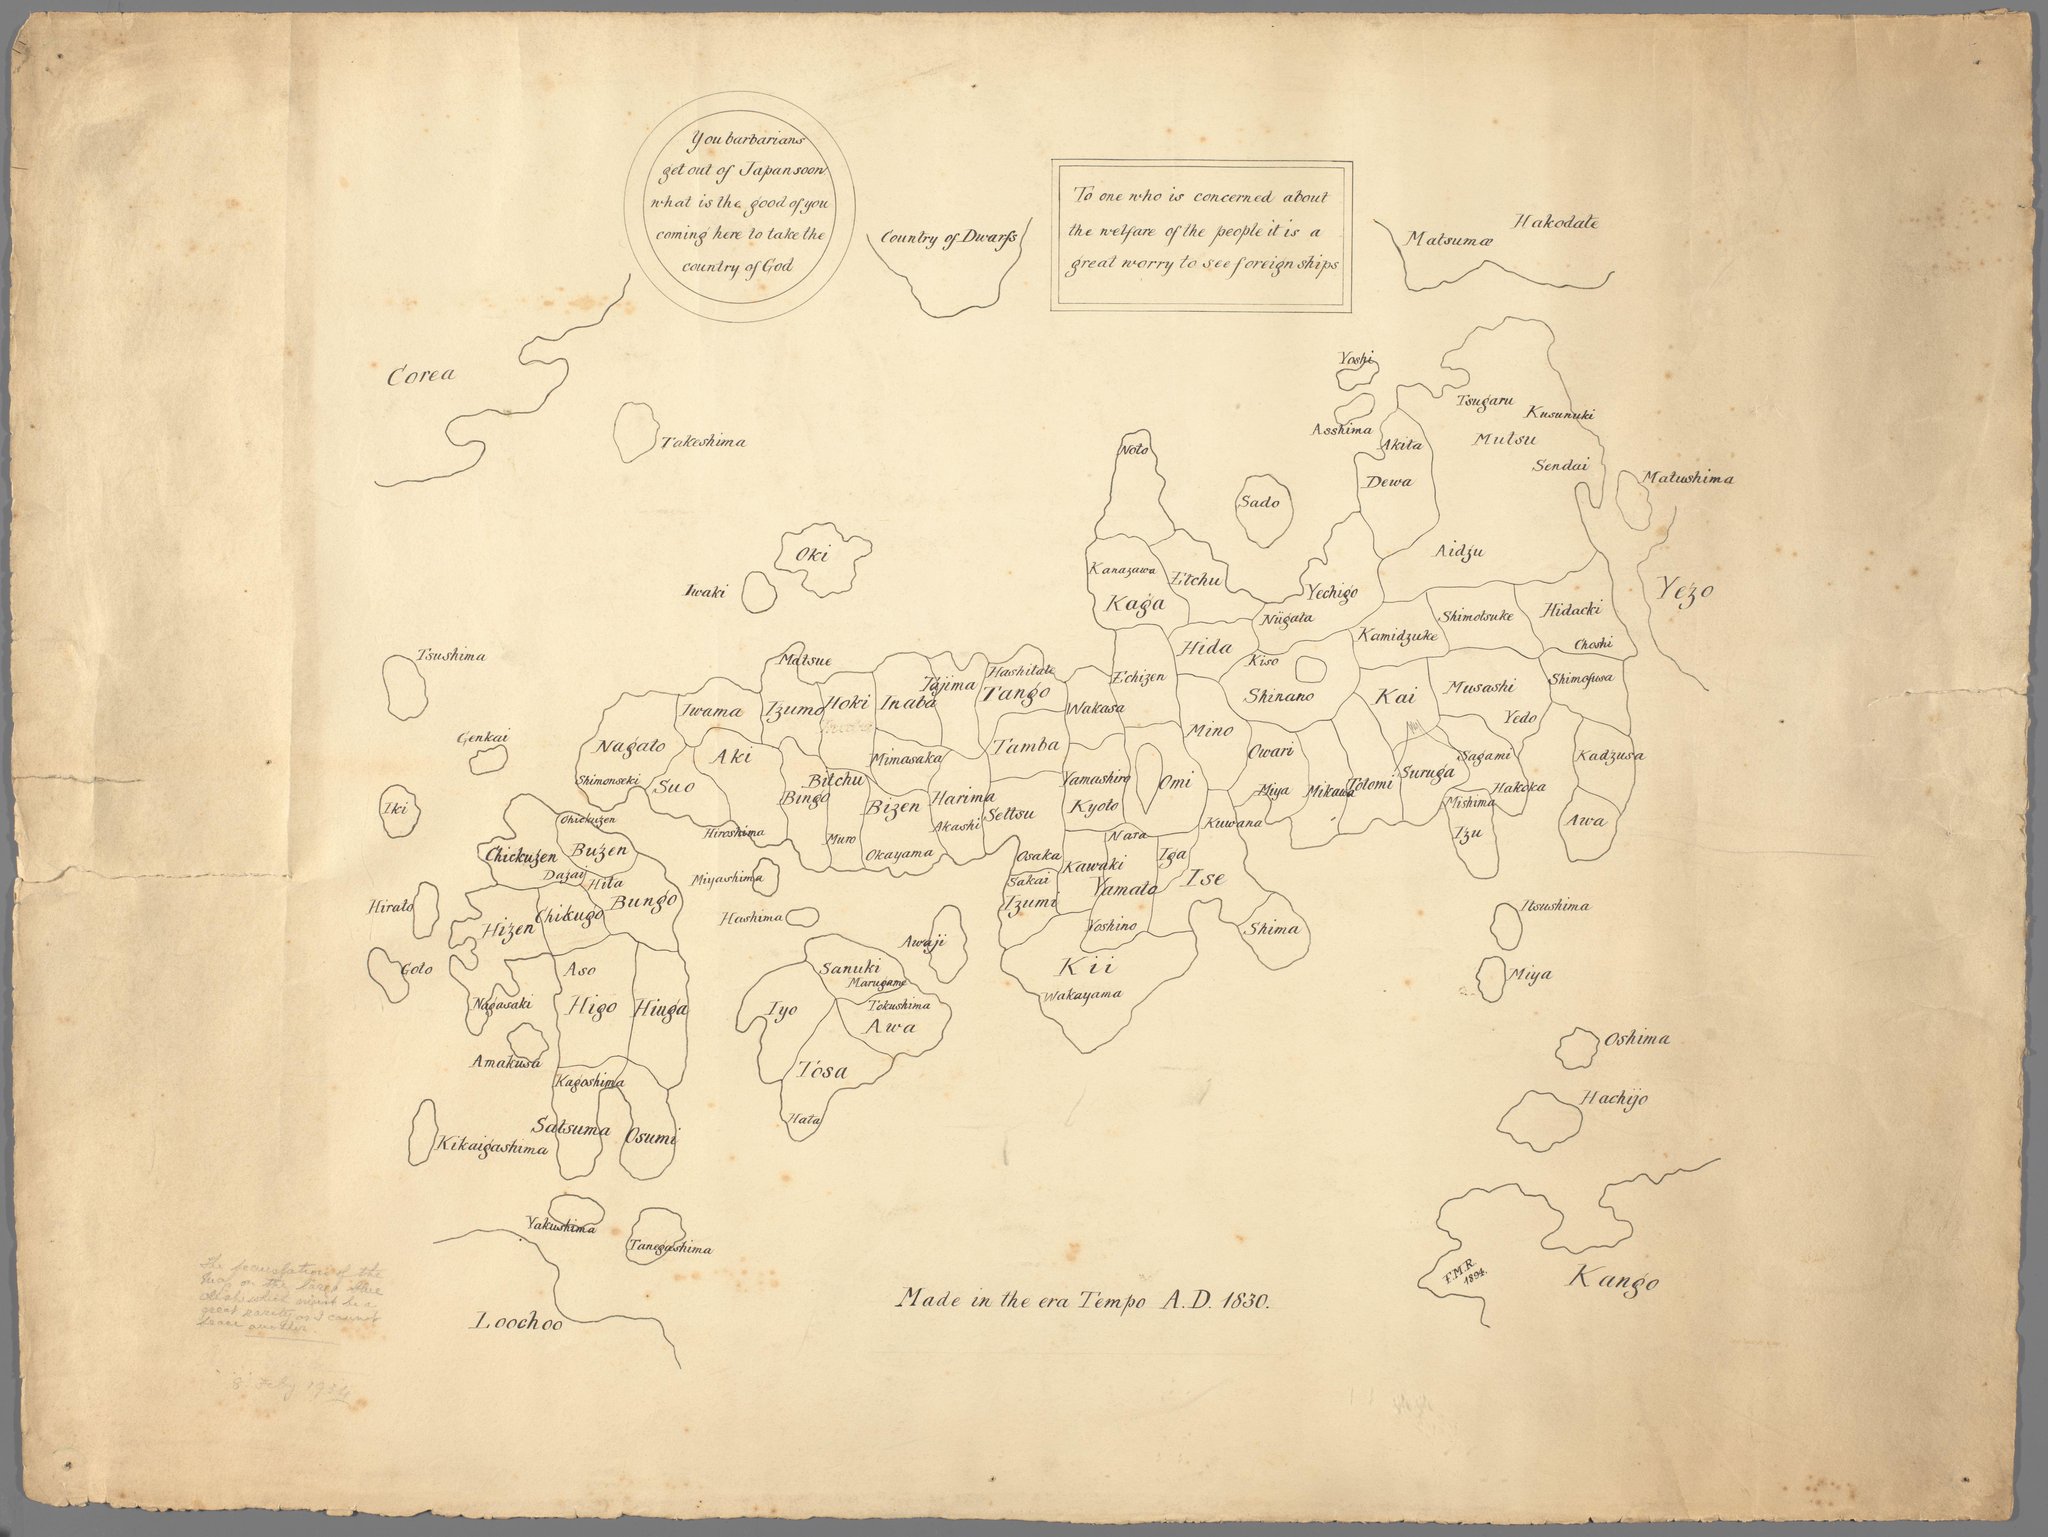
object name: document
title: Document met afbeelding van de Arita-schotel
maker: Anonymous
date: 1830-1844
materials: paper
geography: japan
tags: japan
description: Document waarop de afbeelding van de Arita-schotel is nagetekend, maar alle teksten in het Nederlands zijn aangebracht.